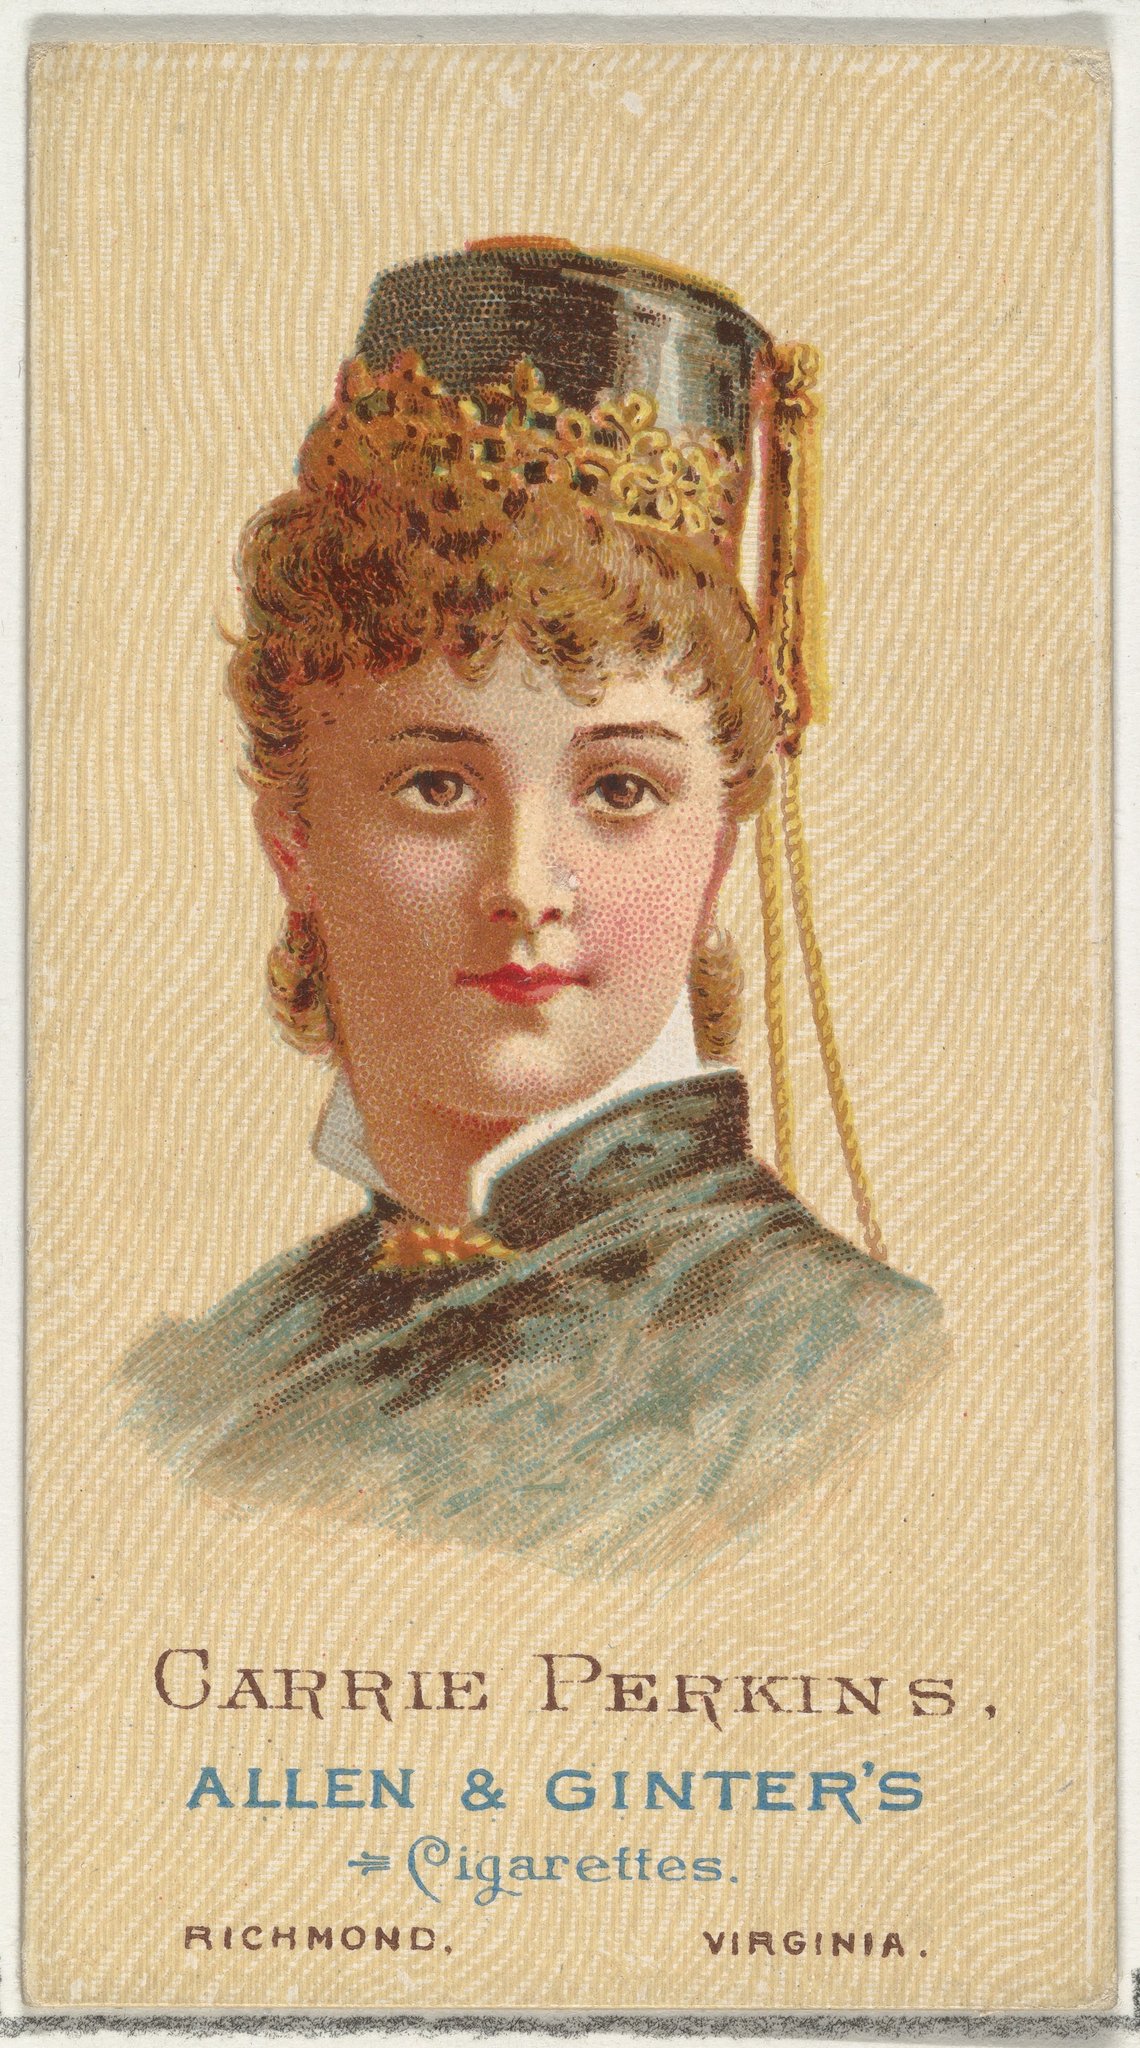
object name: print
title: Carrie Perkins, from World's Beauties, Series 2 (N27) for Allen & Ginter Cigarettes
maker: allen & ginter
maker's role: publisher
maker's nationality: american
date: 1888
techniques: color lithograph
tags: women